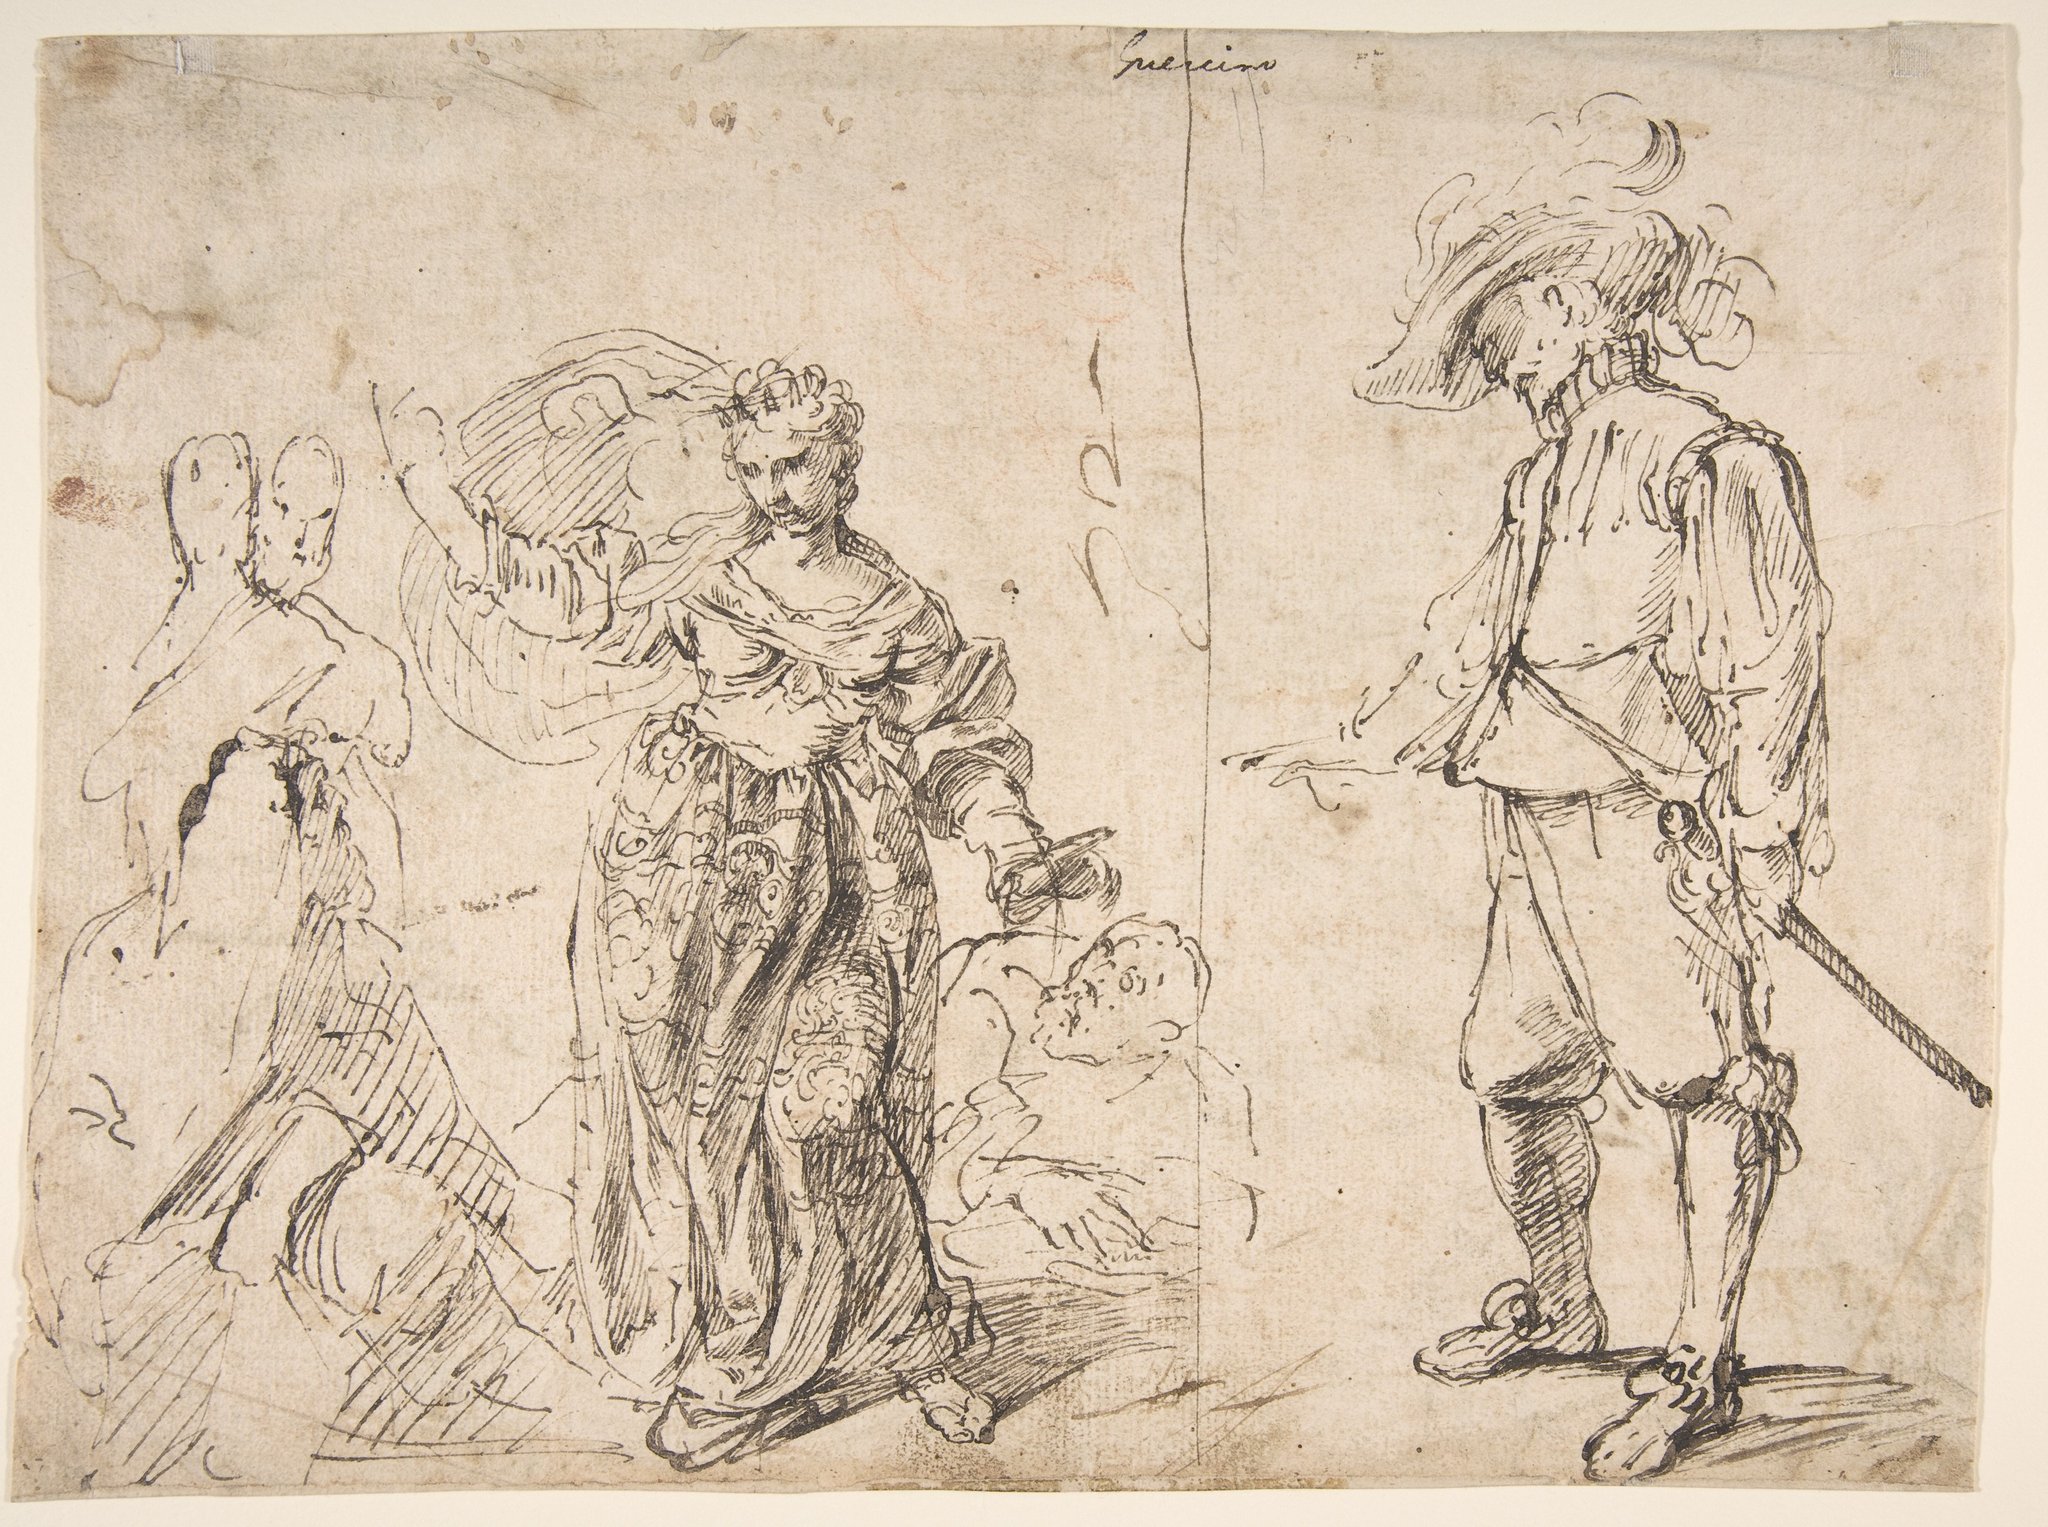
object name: drawing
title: Sheet with Figure Studies (double sided)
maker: pietro novelli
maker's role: artist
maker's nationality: italian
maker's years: 1603-1647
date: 1601-1700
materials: ink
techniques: pen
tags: men,women